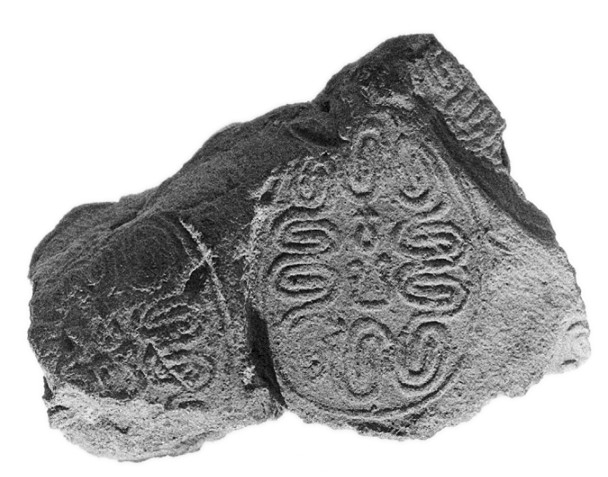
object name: sealing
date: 1981-1640 BCE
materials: clay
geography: egypt